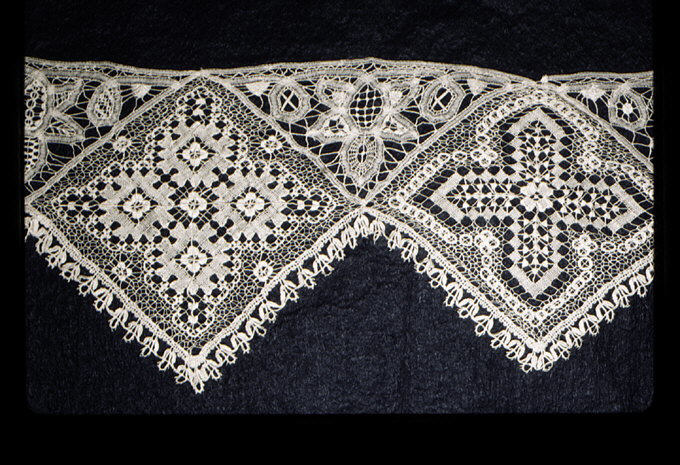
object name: fragment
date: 1867-1900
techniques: embroidery